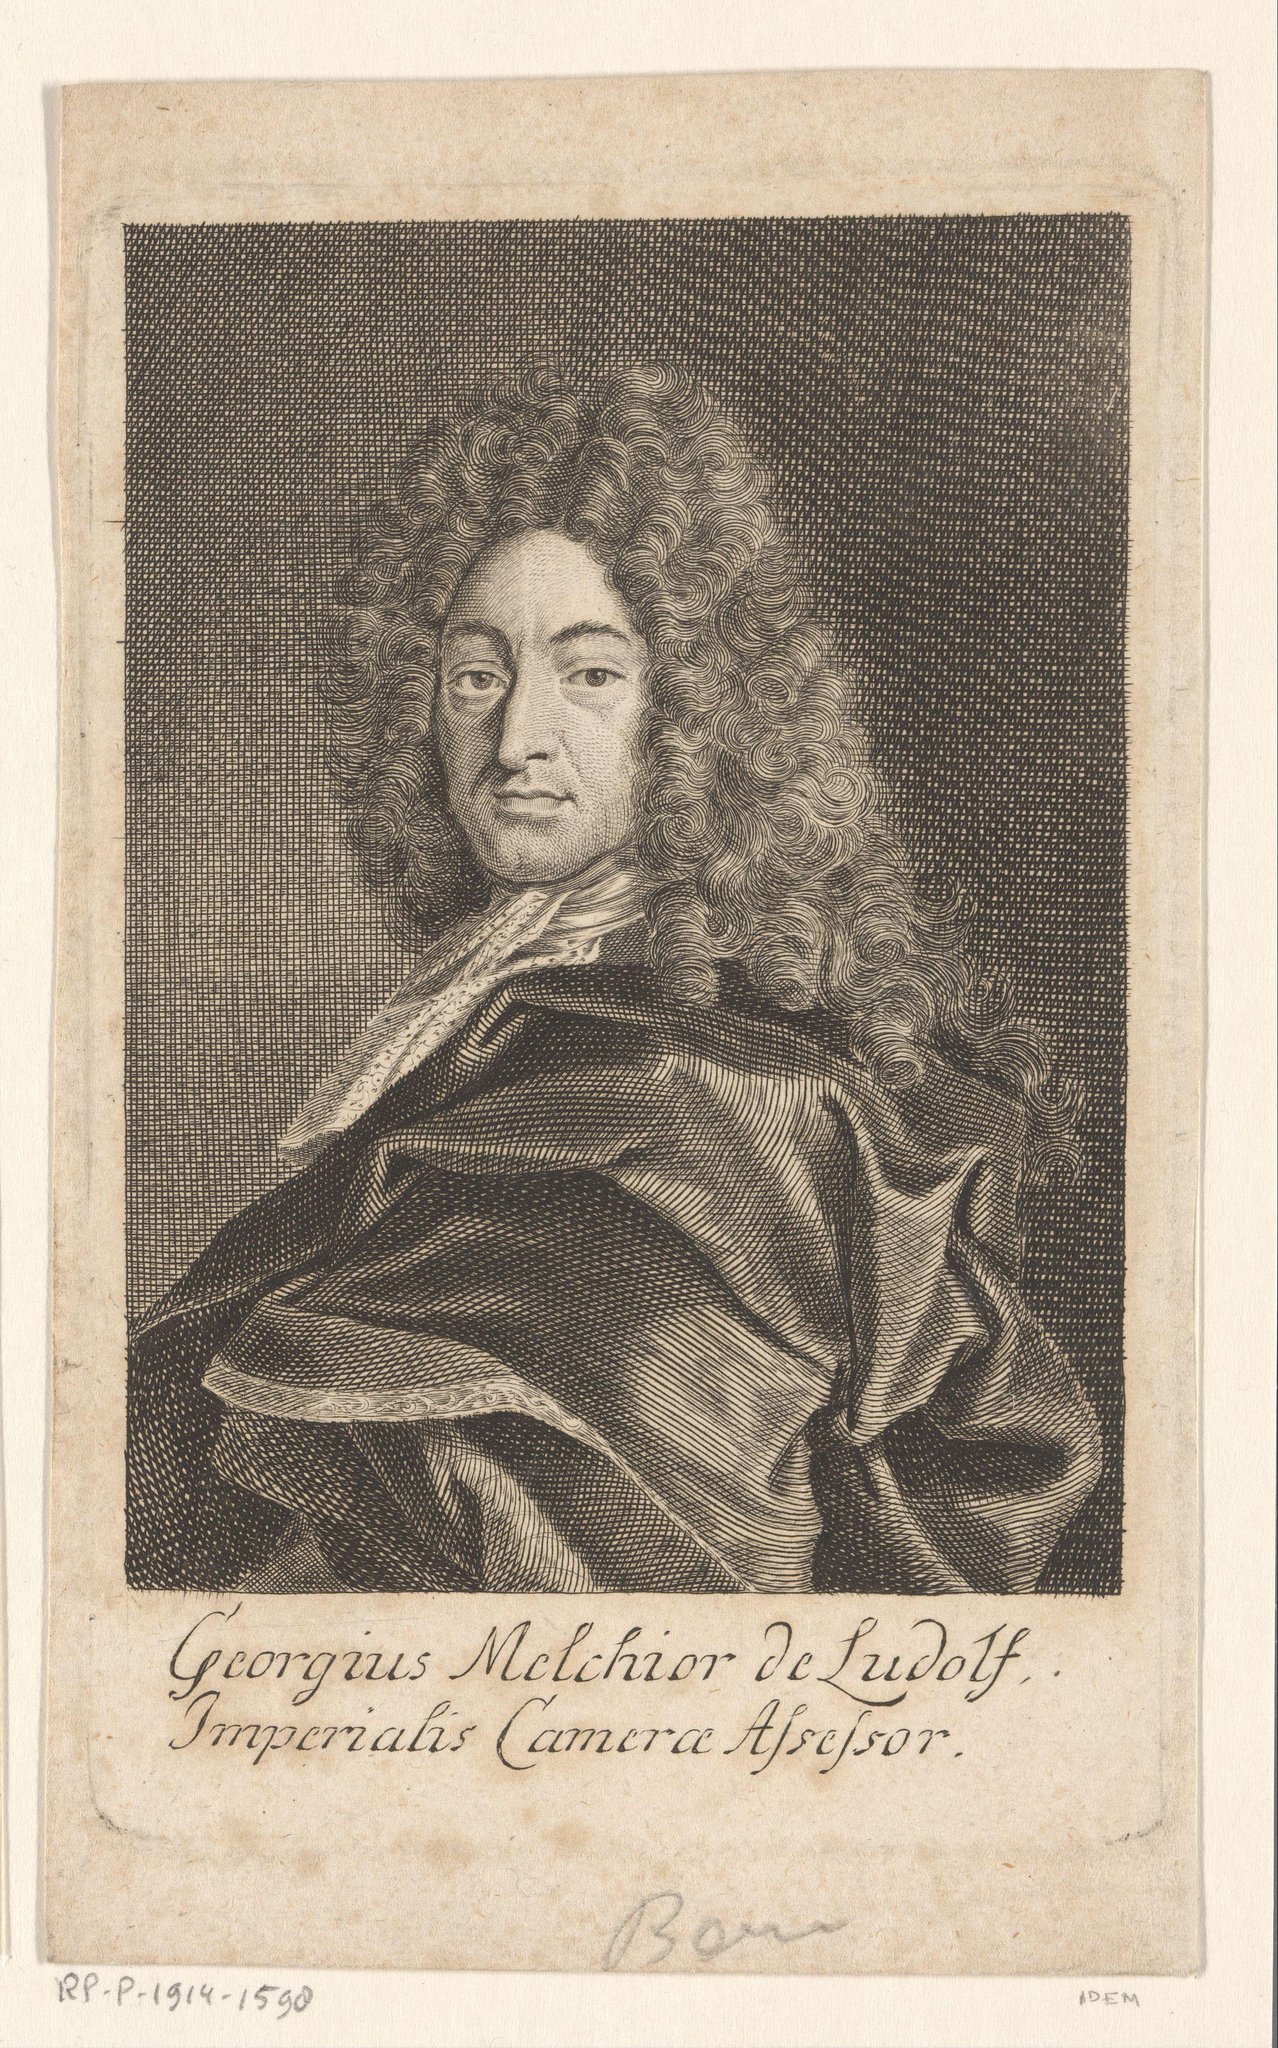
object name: print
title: Portret van Georg Melchior von Ludolf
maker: johann martin bernigeroth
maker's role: print maker, publisher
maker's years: 1713-1767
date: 1722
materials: paper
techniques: engraving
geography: leipzig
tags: historical persons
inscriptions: collector's mark: Lugt 2228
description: Prent ook gebruikt in: Deutsche Acta Eruditorum (...). dl. 78. Leipzig: Johann Gottlieb Gleditsch, 1722.